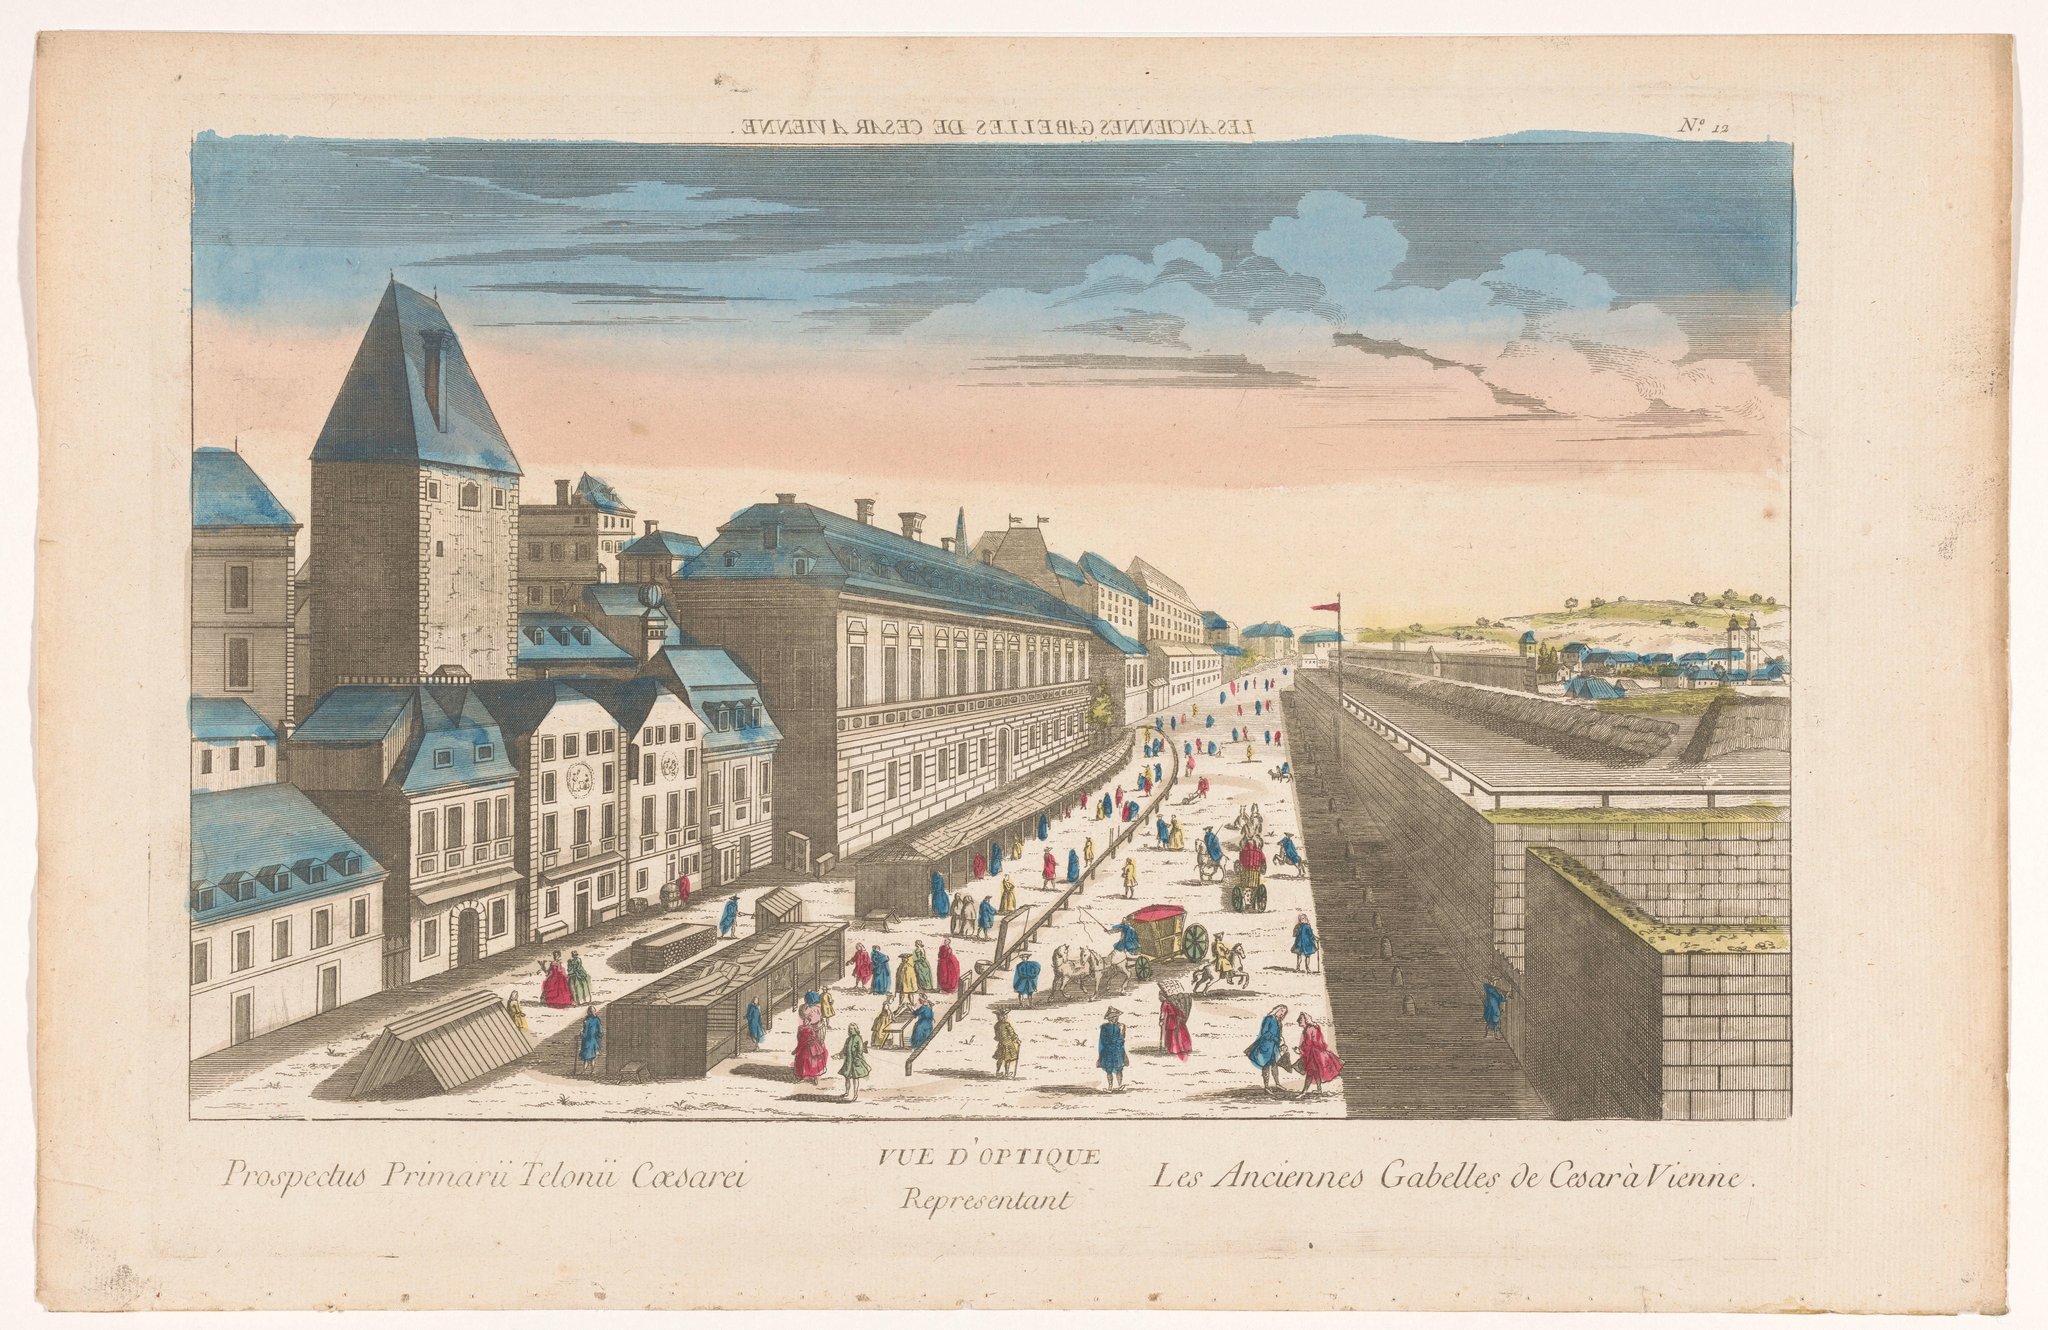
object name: print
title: Vue d'optique representant les anciennes gabelles de Cesar à Vienne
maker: Anonymous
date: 1700-1799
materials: paper, watercolor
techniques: brush, etching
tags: stall, booth (~ market), street (+ city(-scape) with figures, staffage), vienna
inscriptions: watermark, collector's mark: Lugt 2166